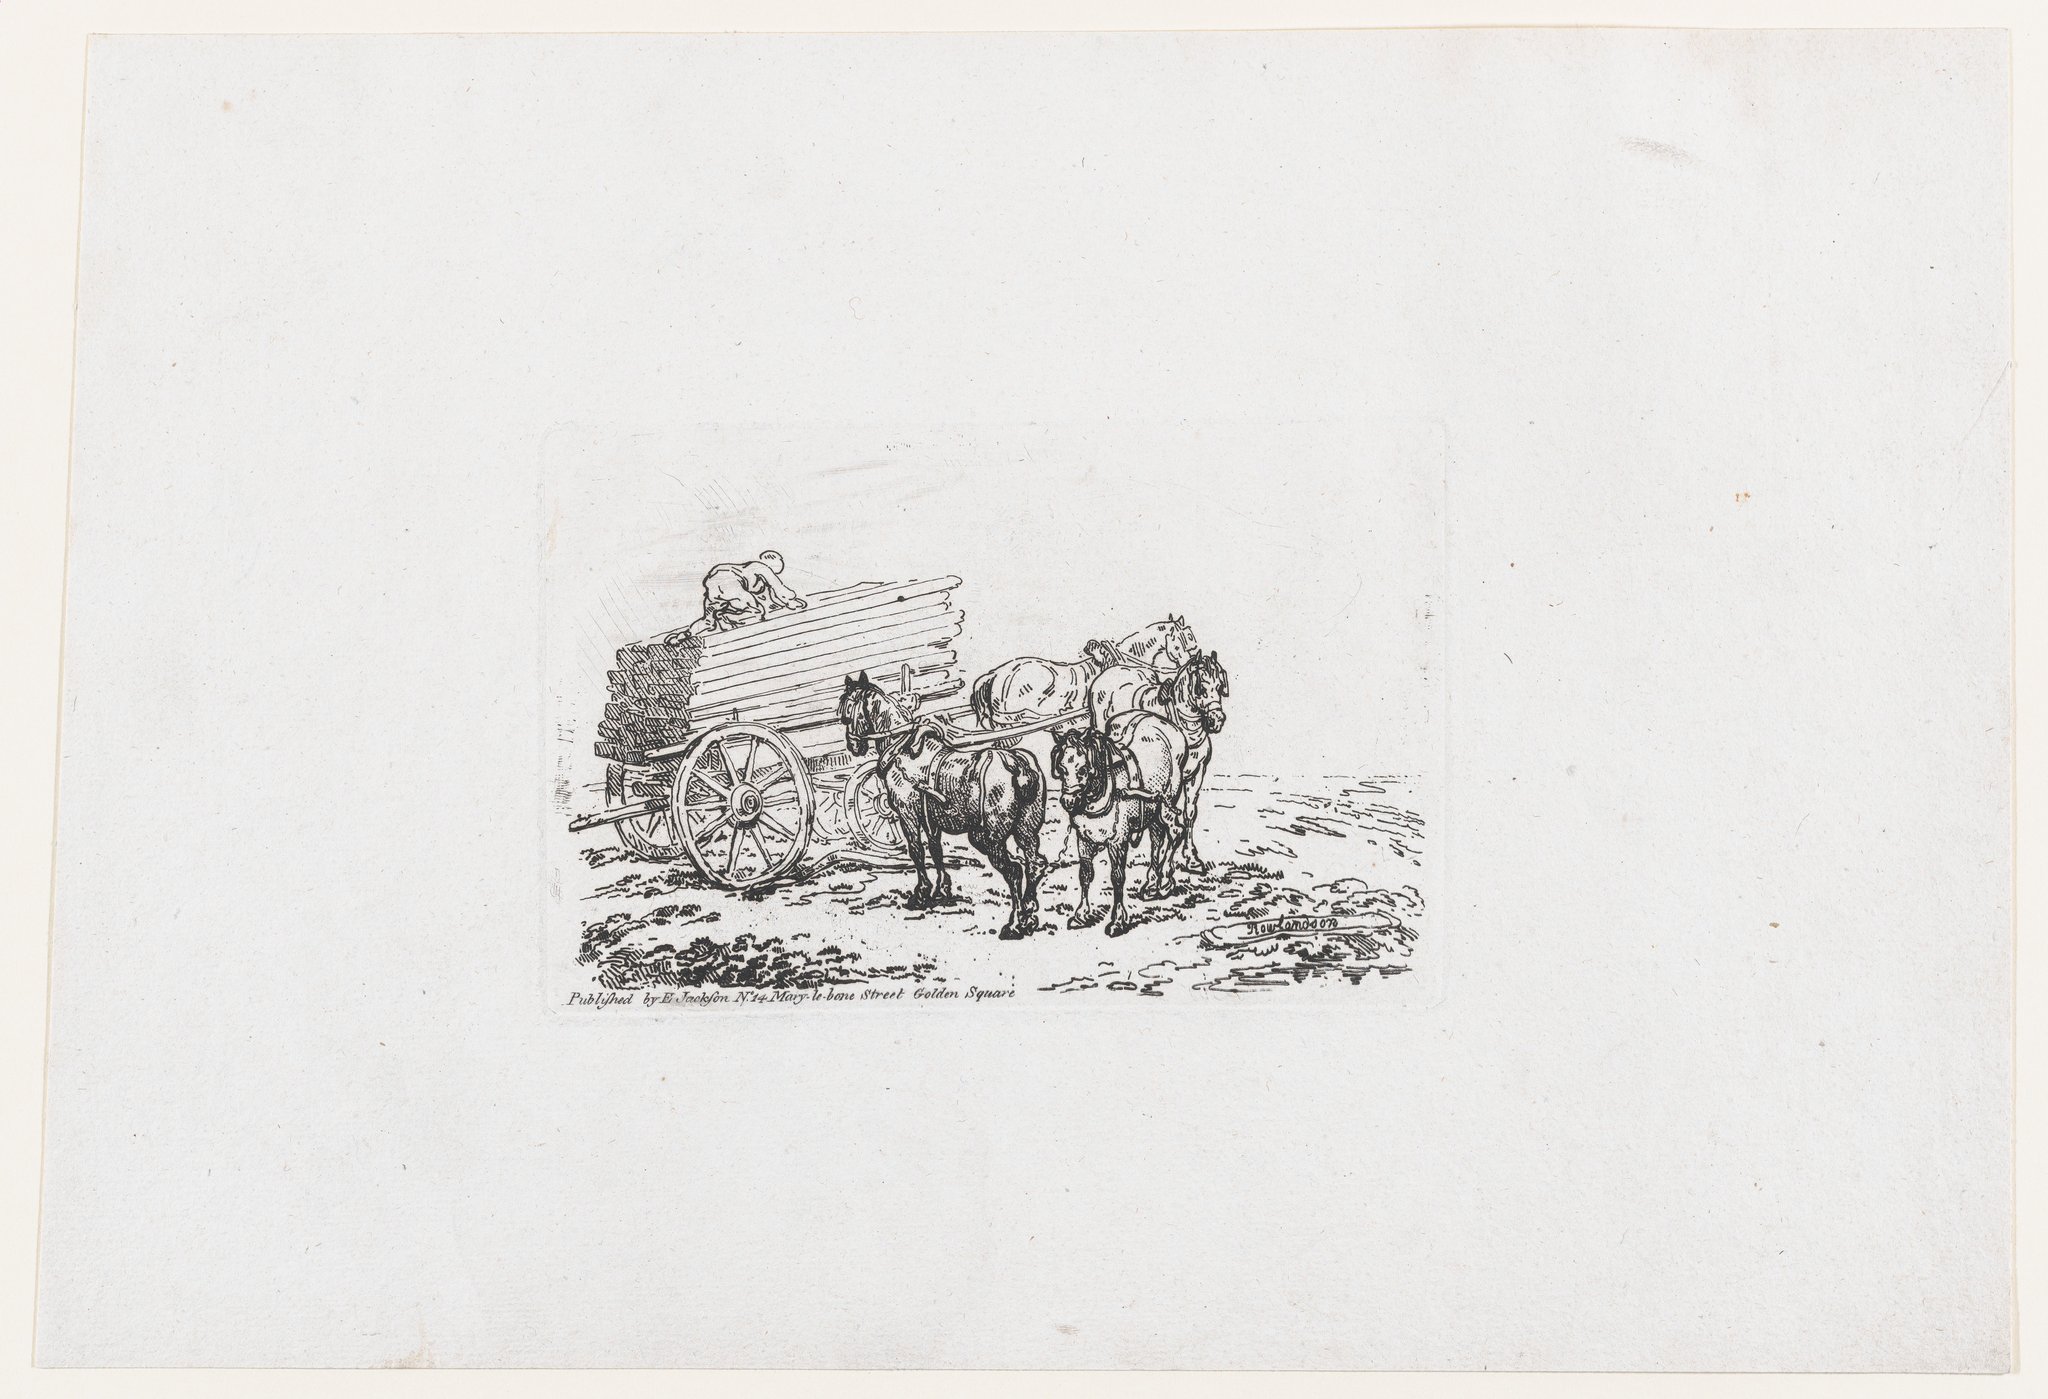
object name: print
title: A Timber Waggon, from The Rhedarium, or, A New Book of Horses and Carriages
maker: thomas rowlandson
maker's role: artist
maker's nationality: british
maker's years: 1757-1827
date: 1784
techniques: etching, stippling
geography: london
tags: human figures,horses,carriages